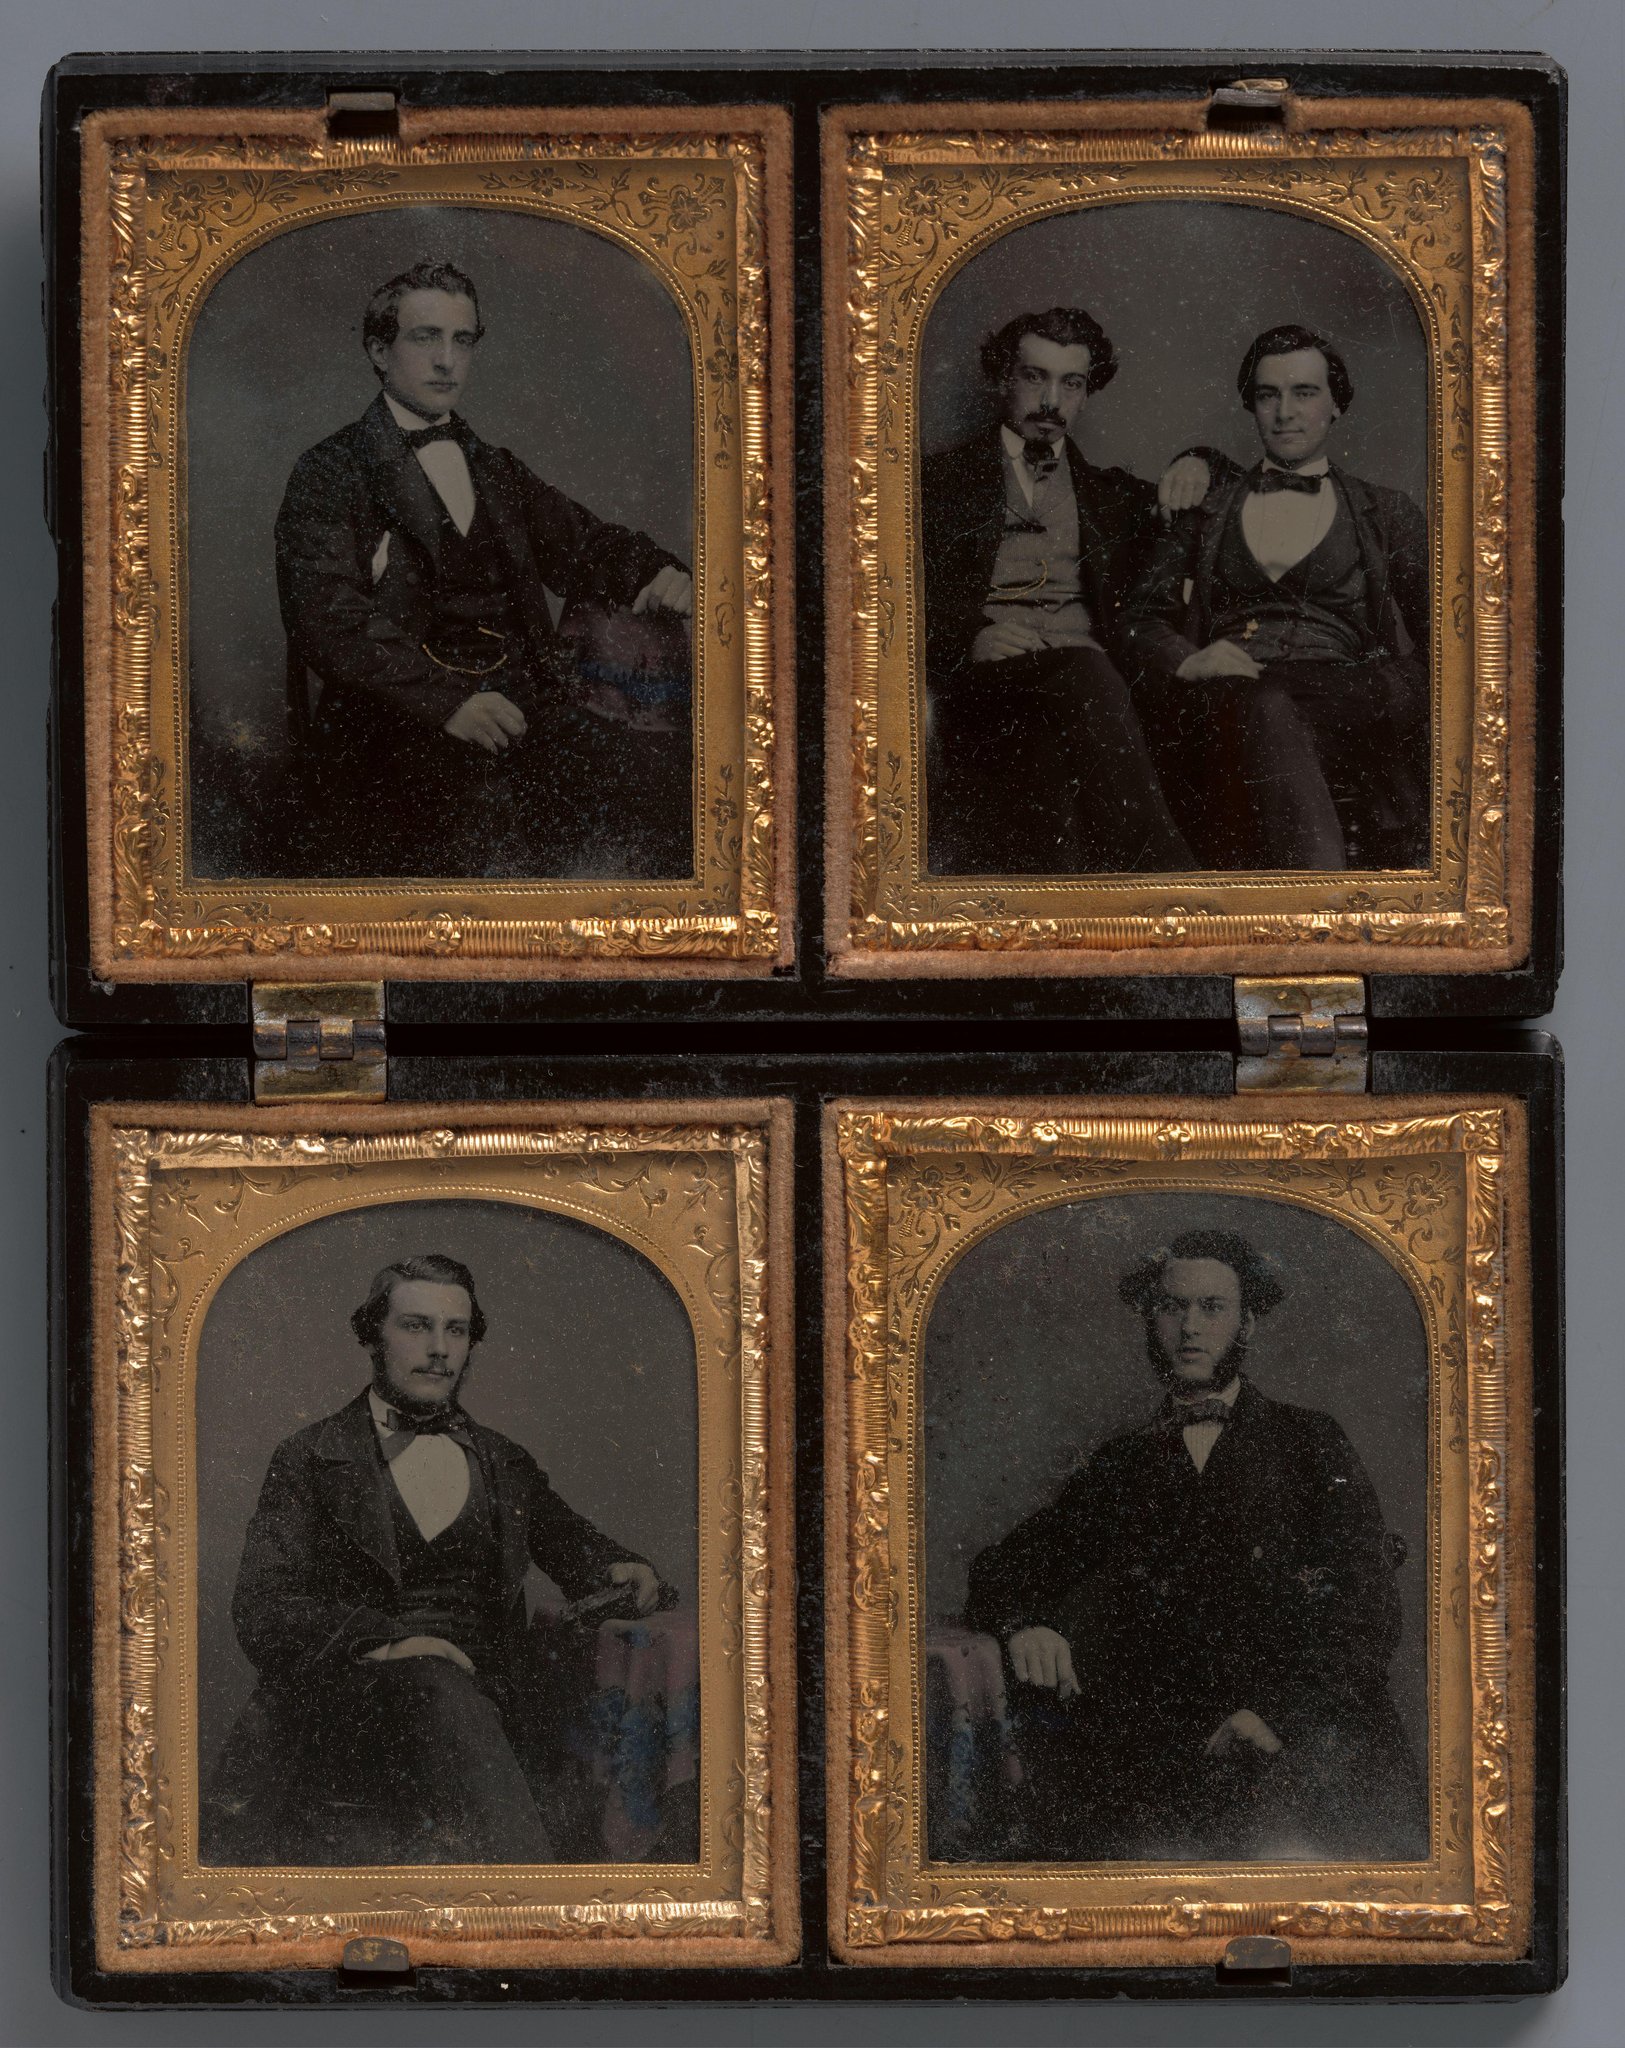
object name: union case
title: Portret een onbekende zittende jongeman met bakkebaarden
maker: Anonymous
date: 1859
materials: glass, metal, plastic, textile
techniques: ambrotype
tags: sideburns, sitting figure, historical persons